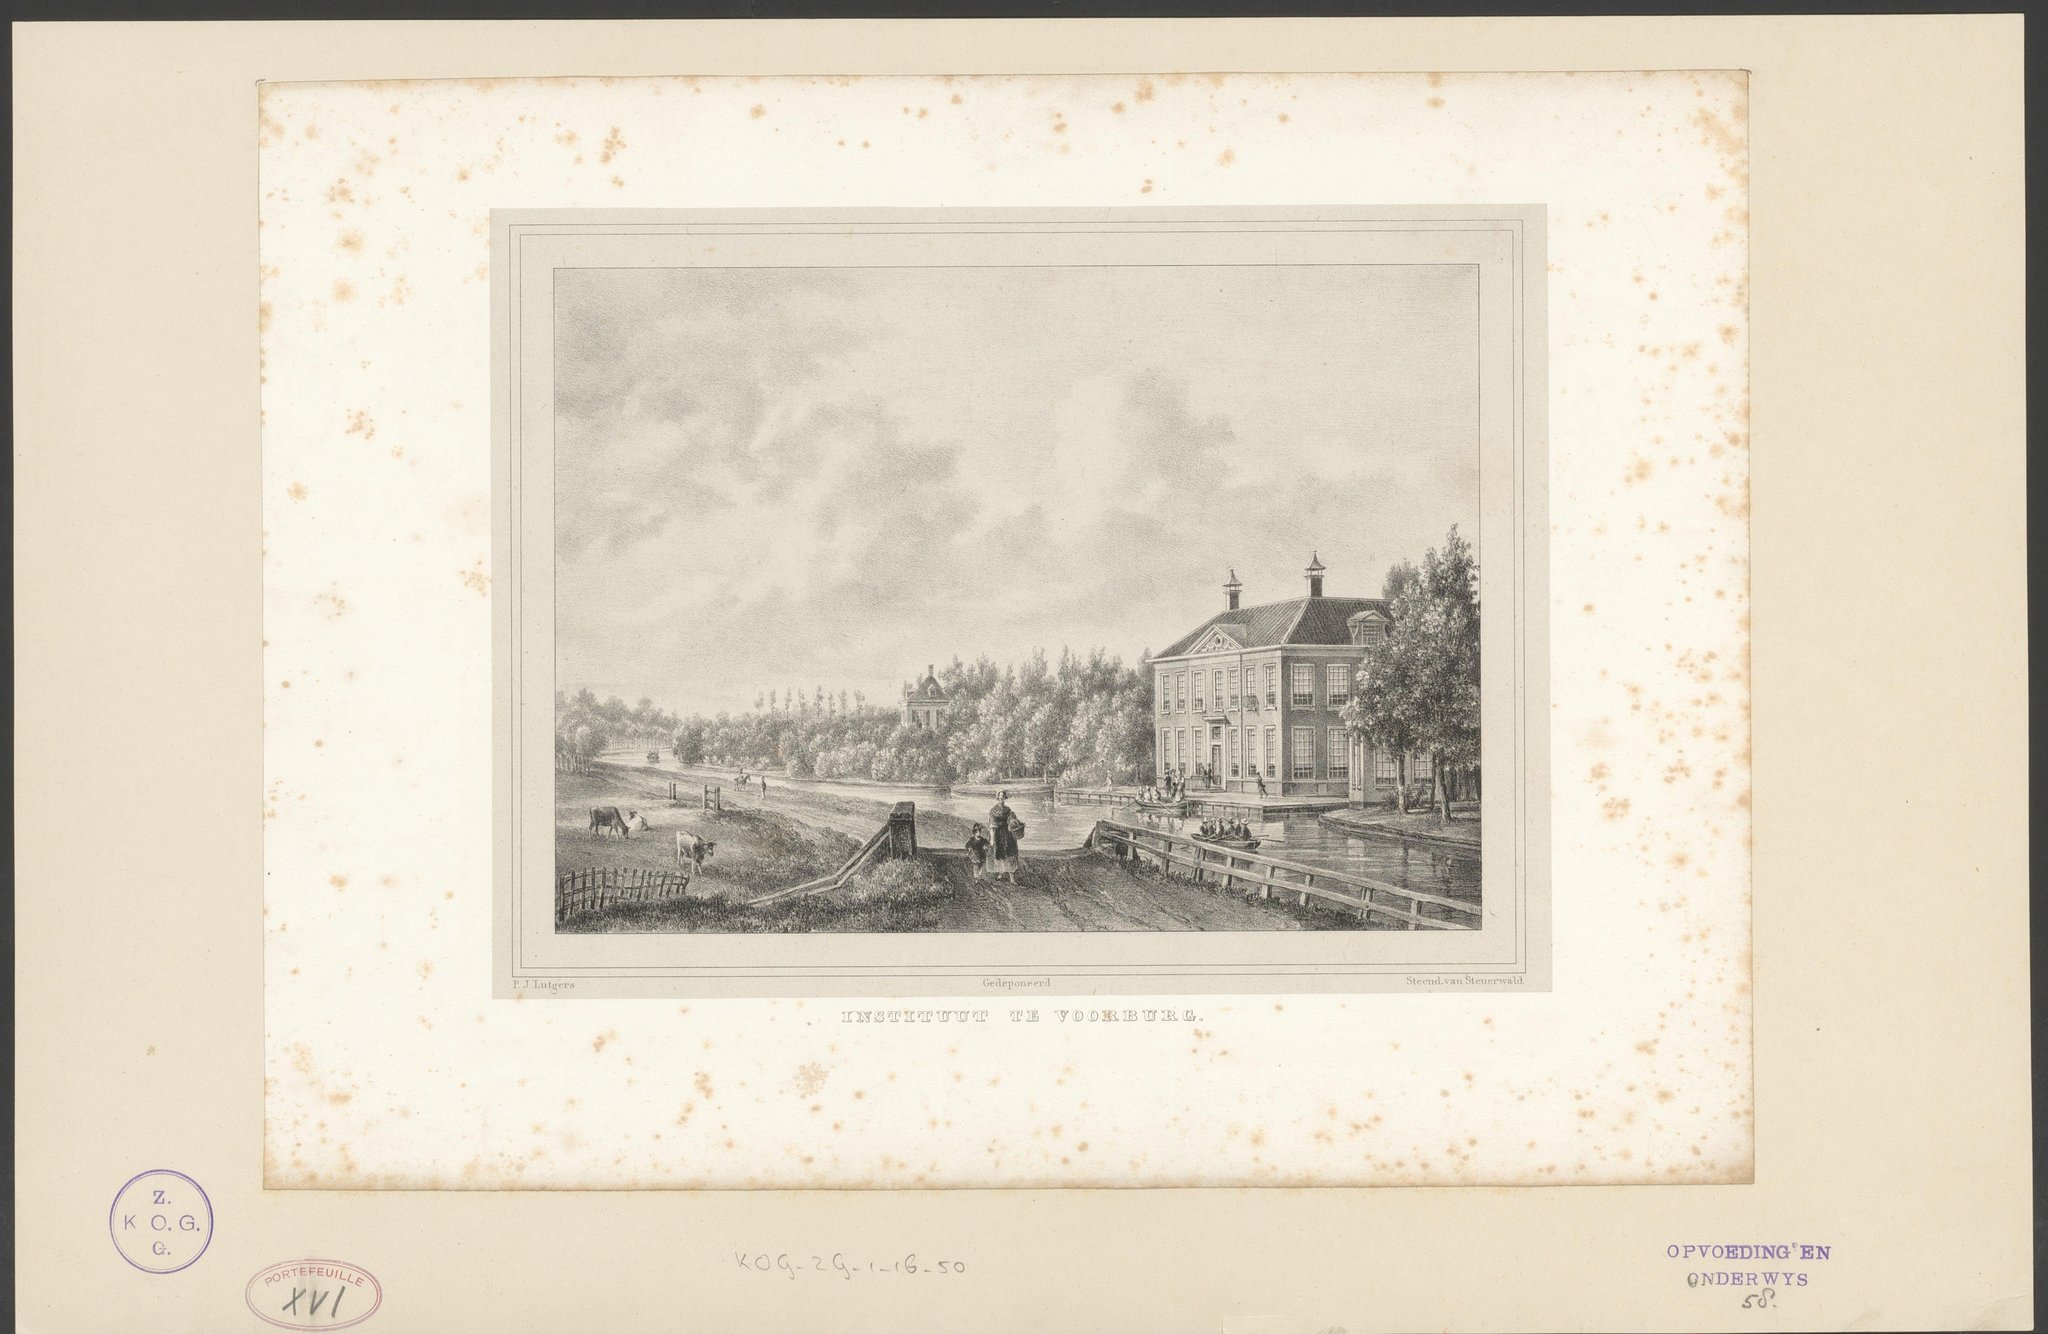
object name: book illustration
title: Instituut te Voorburg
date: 1855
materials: paper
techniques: lithograph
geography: the hague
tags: elementary school; class, form, voorburg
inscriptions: stamp, stamp, collector's mark: Lugt 1641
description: Onderwerpsrubrieken binnen de Atlas Zeden en Gewoonten: Onderwijs en Wetenschappen, Opvoeding en Onderwijs, Gebouwen voor het onderwijs bestemd.